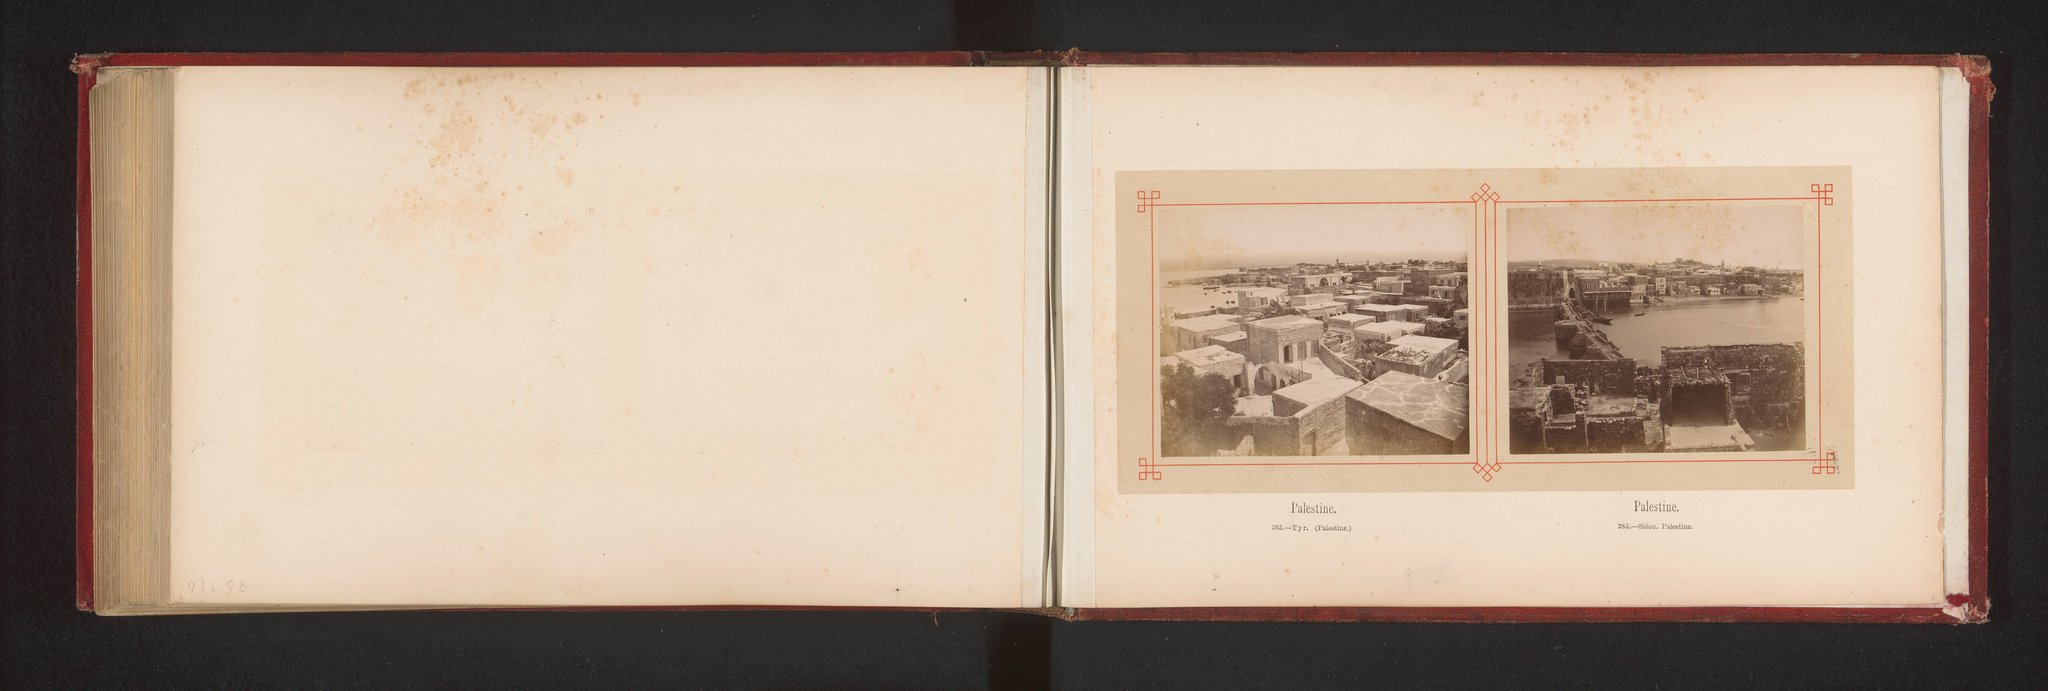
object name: photograph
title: Palestine - 285. Sidon Palestine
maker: félix bonfils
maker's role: fotograaf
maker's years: 1831-1885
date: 1873-1878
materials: photographic support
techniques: albumen print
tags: city-view in general; 'veduta', landscapes with waters, waterscapes, seascapes (in the temperate zone)